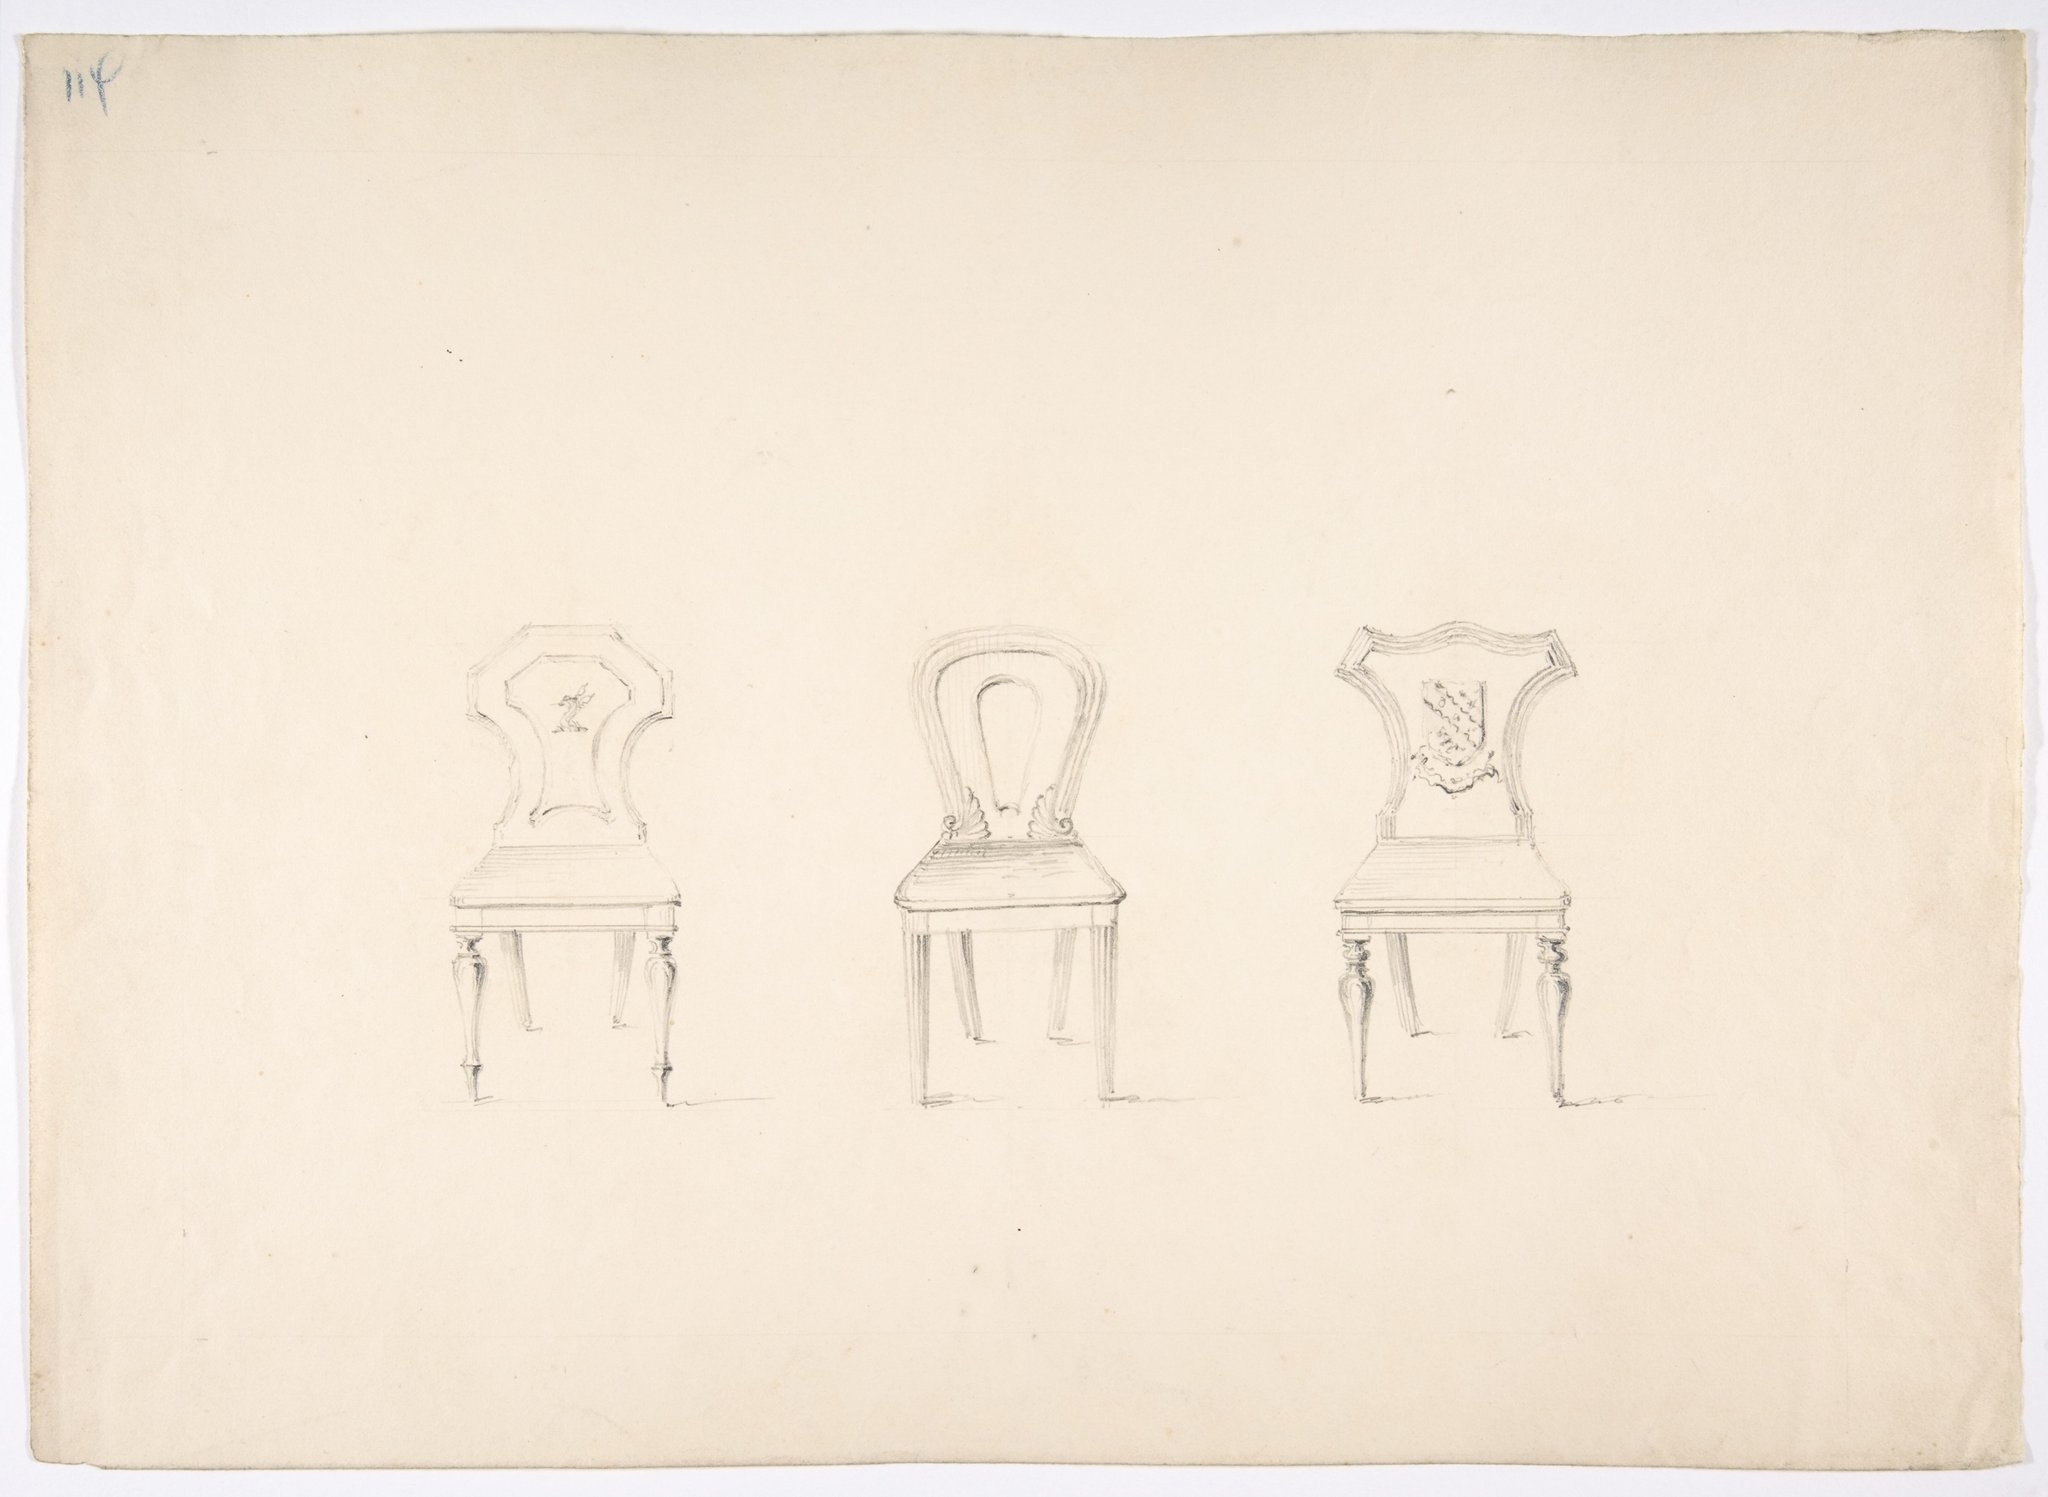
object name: drawing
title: Design for Three Chairs, Two with Armorial Ornament on Backs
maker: anonymous, british, 19th century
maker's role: artist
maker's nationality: british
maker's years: 1800-1900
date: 1801-1833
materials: graphite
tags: chairs